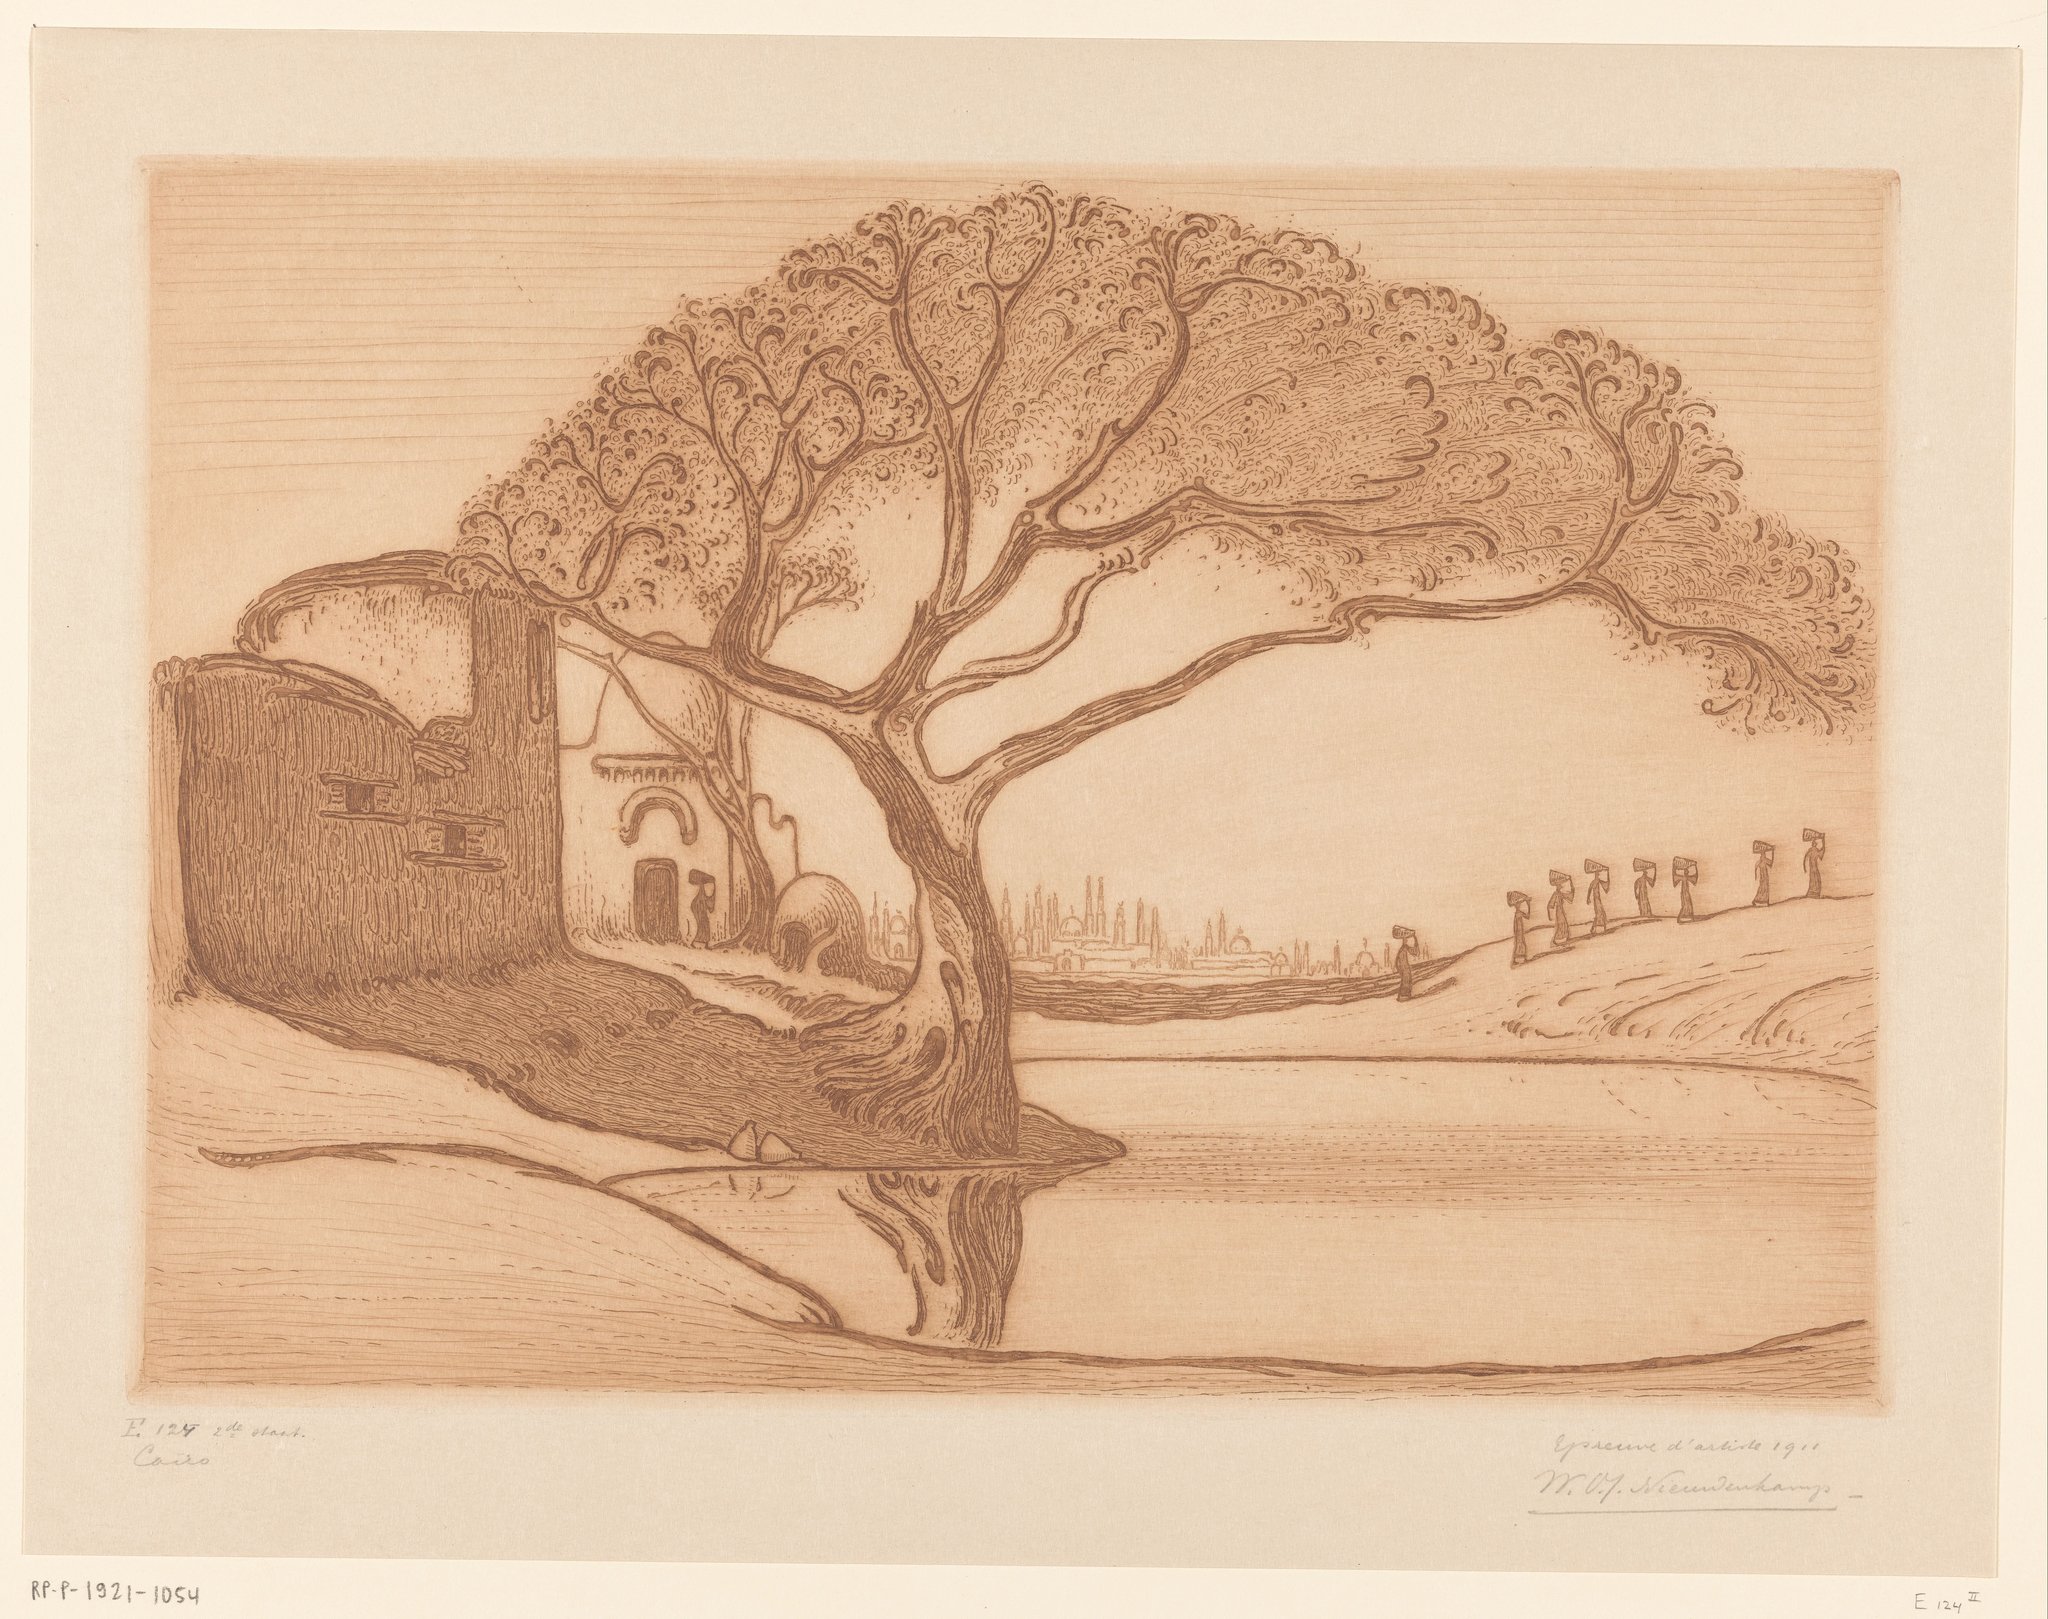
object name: print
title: Caïro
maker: wijnand otto jan nieuwenkamp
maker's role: draughtsman, print maker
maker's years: 1874-1950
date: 1911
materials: paper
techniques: aquatint, intaglio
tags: trees, pond, pool, prospect of city, town panorama, silhouette of city, carrying something on the head or on the shoulders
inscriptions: collector's mark: Lugt 2233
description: Links enkele gebouwen. Rechts vrouwen die waterkruiken op hun hoofd dragen. Op de achtergrond het silhouet van Caïro.